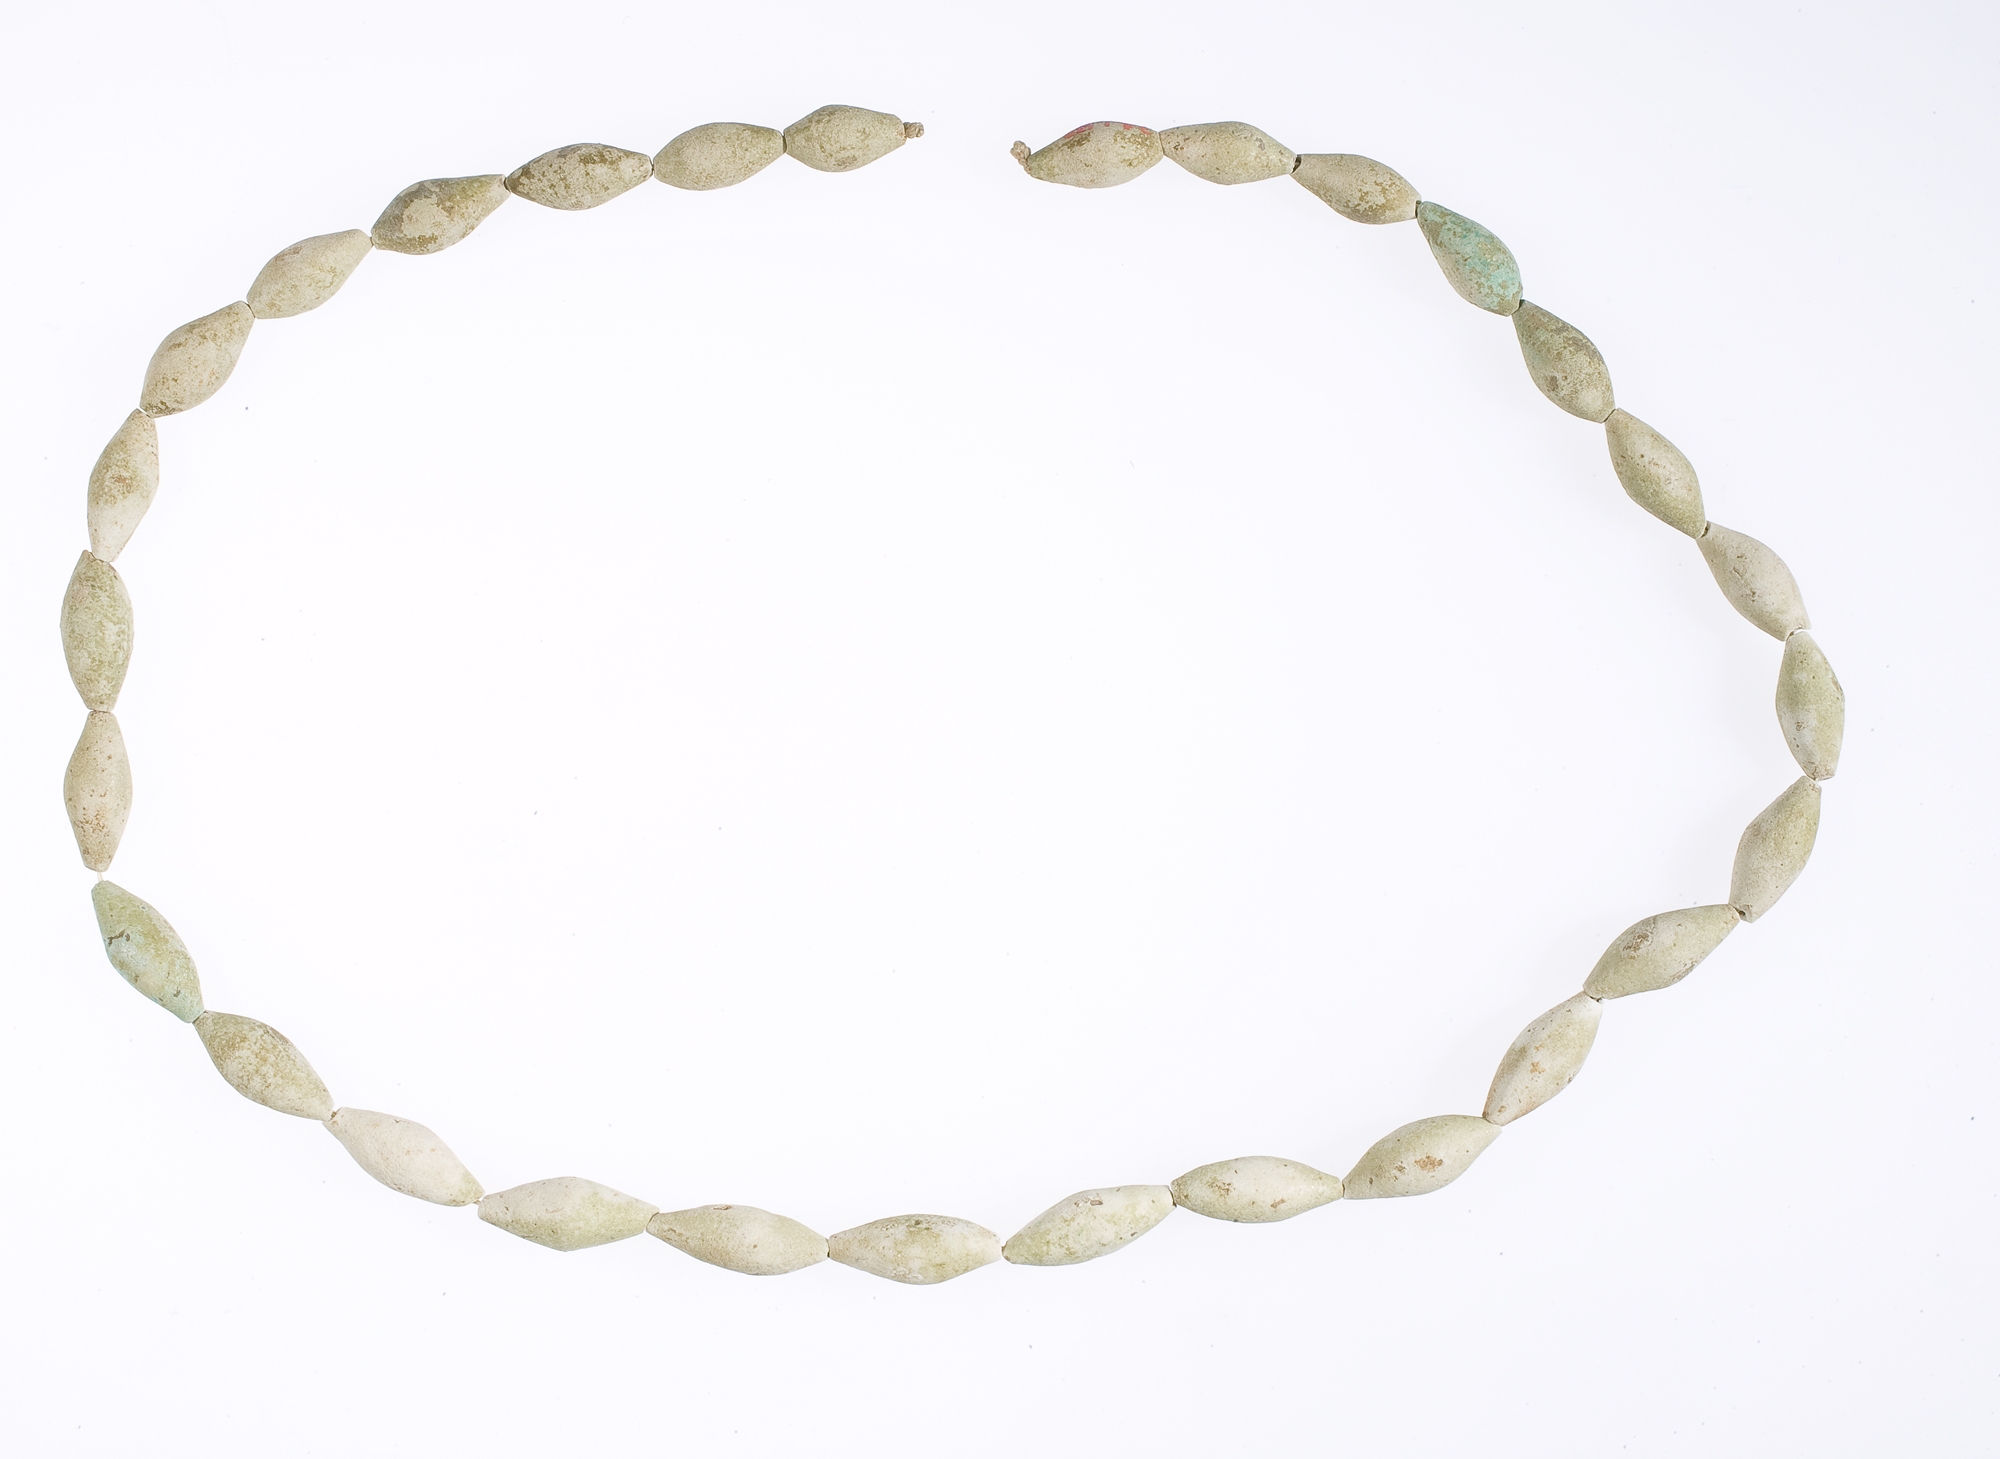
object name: bead, found scattered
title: Hepy, found scattered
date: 1950-1885 BCE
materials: faience, glaze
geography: egypt